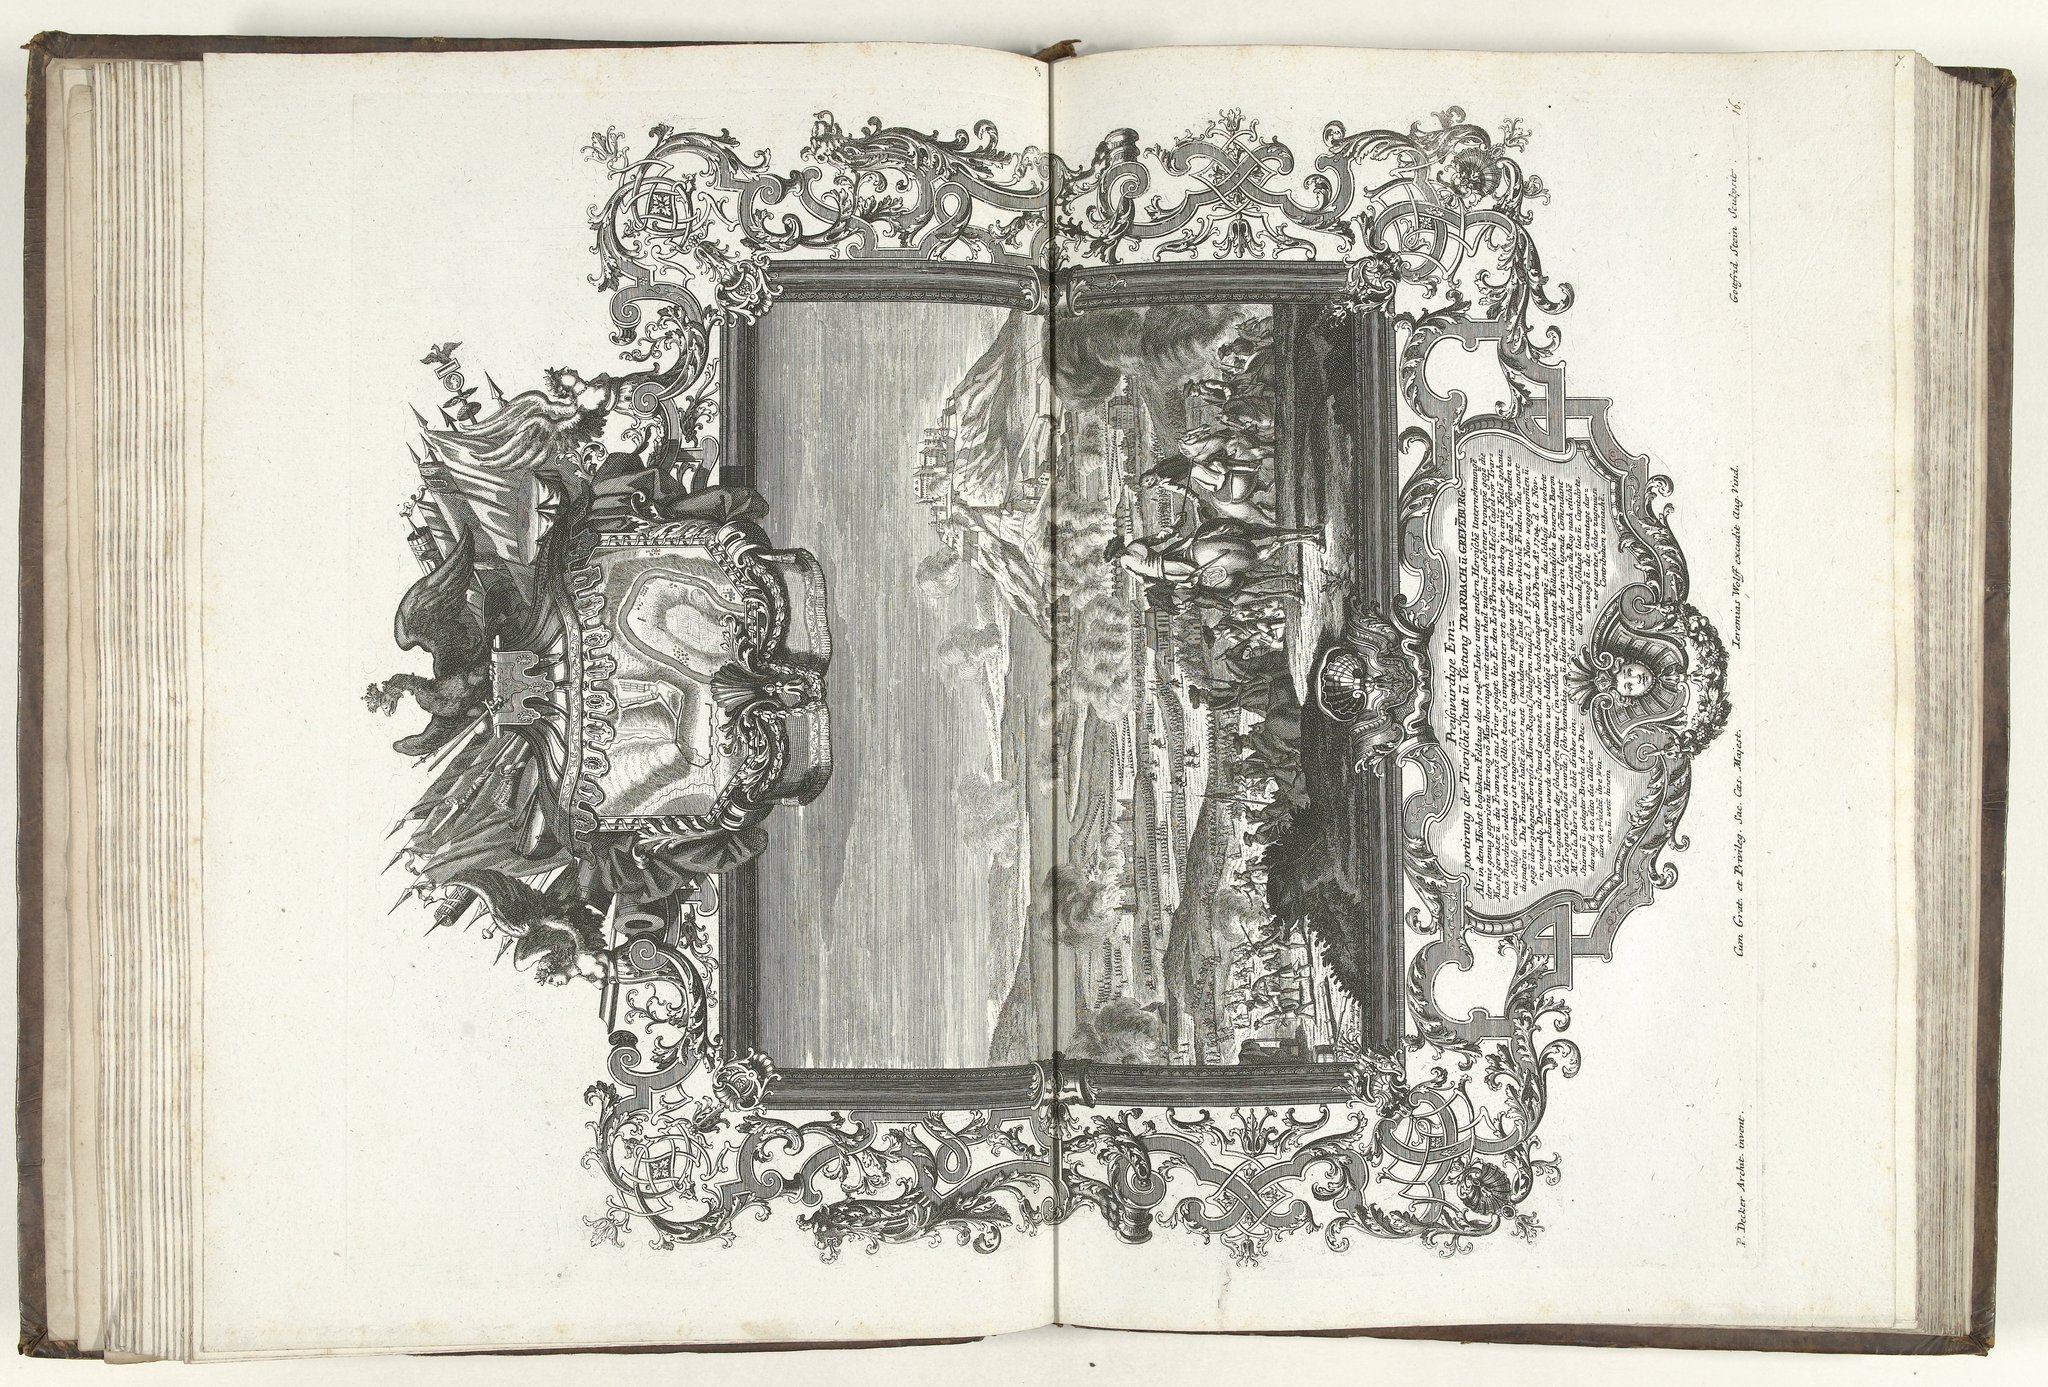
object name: print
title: Preisswürdige Emportierung der Trierische Statt u. Vestung Trarbach u. Greveburg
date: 1712-1715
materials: paper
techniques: engraving, etching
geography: augsburg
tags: siege, position war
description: Beleg van het kasteel van Trarbach door de geallieerden vanaf 14 november, inname op 18 december 1704. Voorstelling van het beleg in een rijk versierde ornamentele omlijsting met bovenaan een cartouche met een kaart van de ligging van het kasteel, bekroond met de Duitse adelaar en vaandels. Onderaan een cartouche met de beschrijving van het gevecht in het Duits. Blad in de gebonden verzameling platen uitgebracht onder de titel: Repraesentatio belli ... Der Spanische Successions-Krieg [ca. 1720].